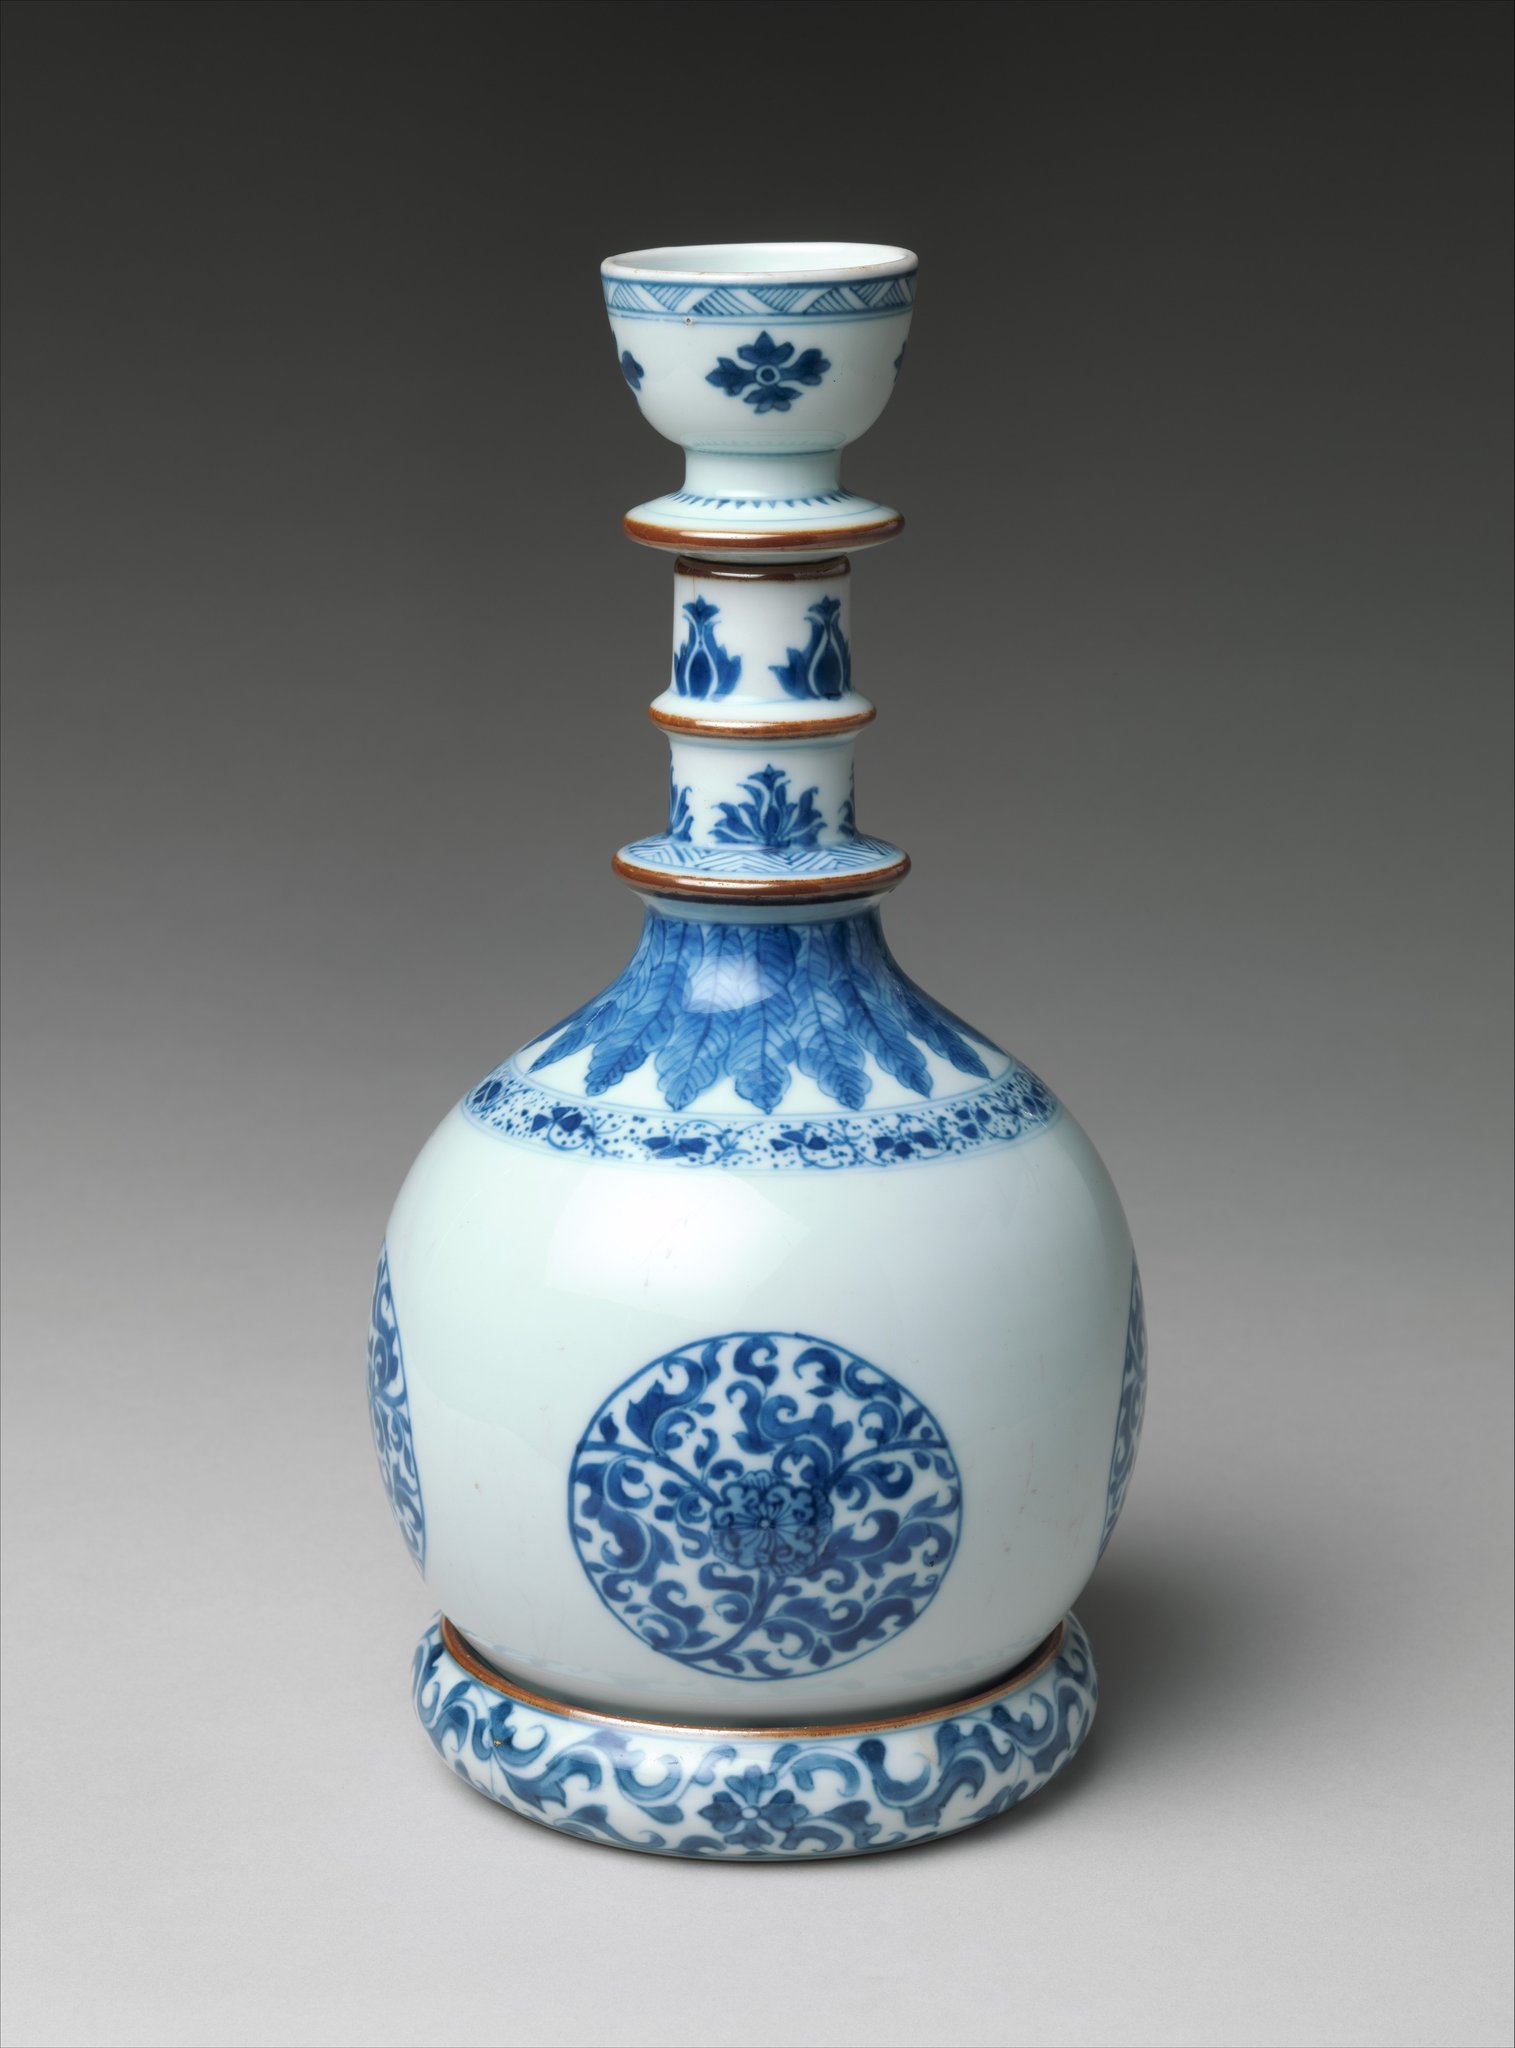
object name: huqqa base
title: Base for a Water Pipe (huqqa) with Floral Medallions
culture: chinese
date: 1701-1733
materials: cobalt, glaze, porcelain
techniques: painting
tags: flowers